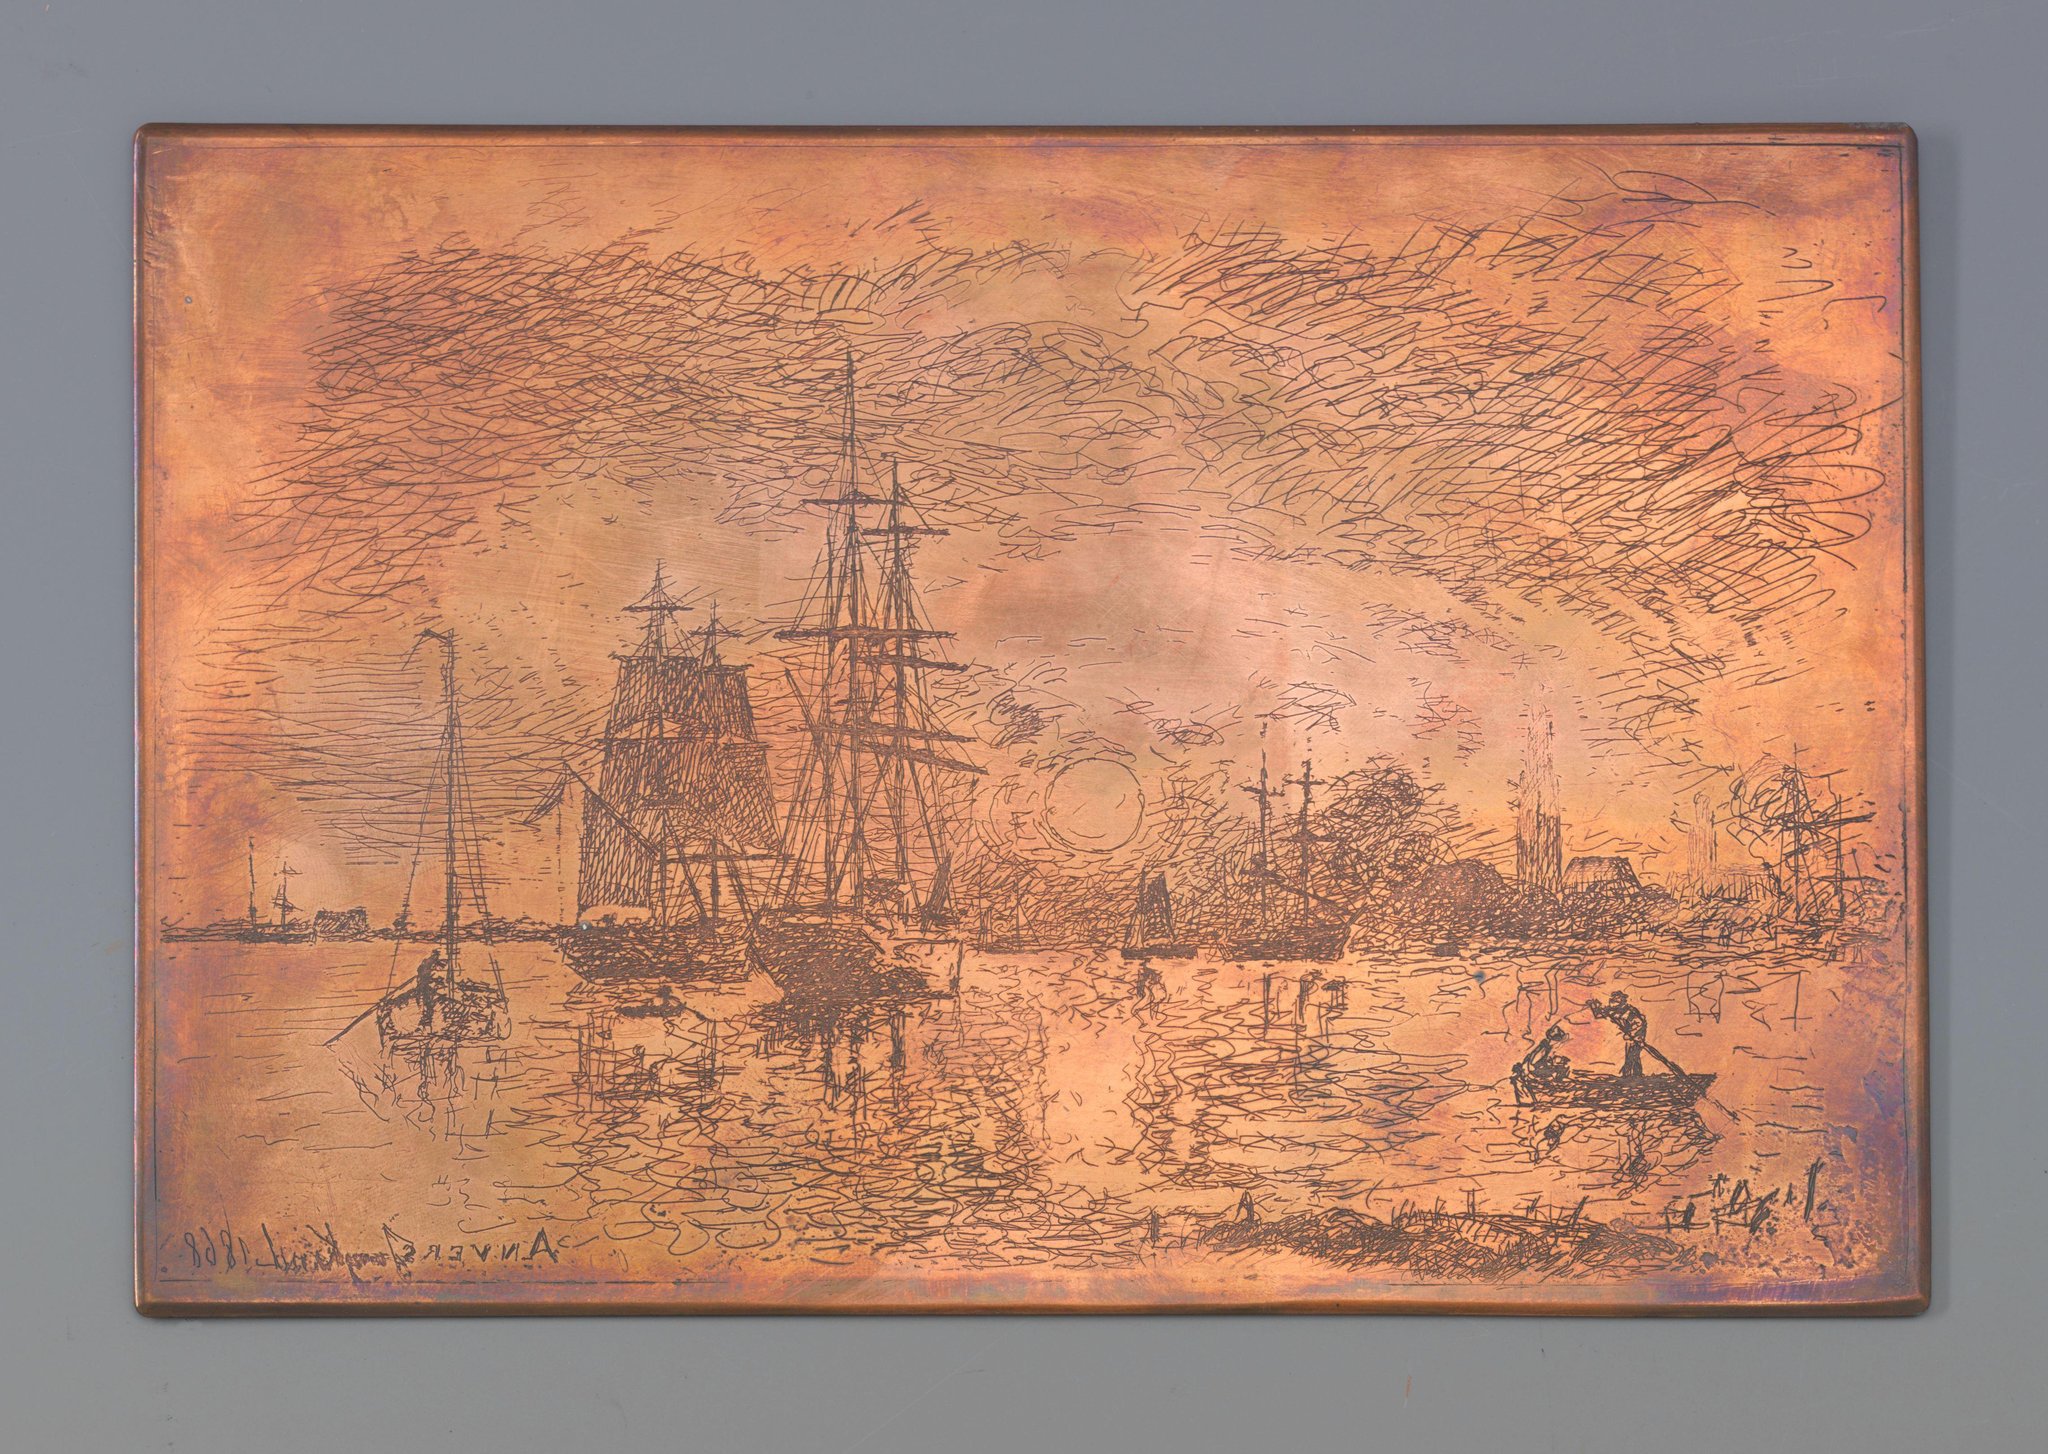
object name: copper plate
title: Haven van Antwerpen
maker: johan barthold jongkind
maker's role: draughtsman, painter, print maker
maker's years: 1819-1891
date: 1868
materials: copper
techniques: etching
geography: antwerp